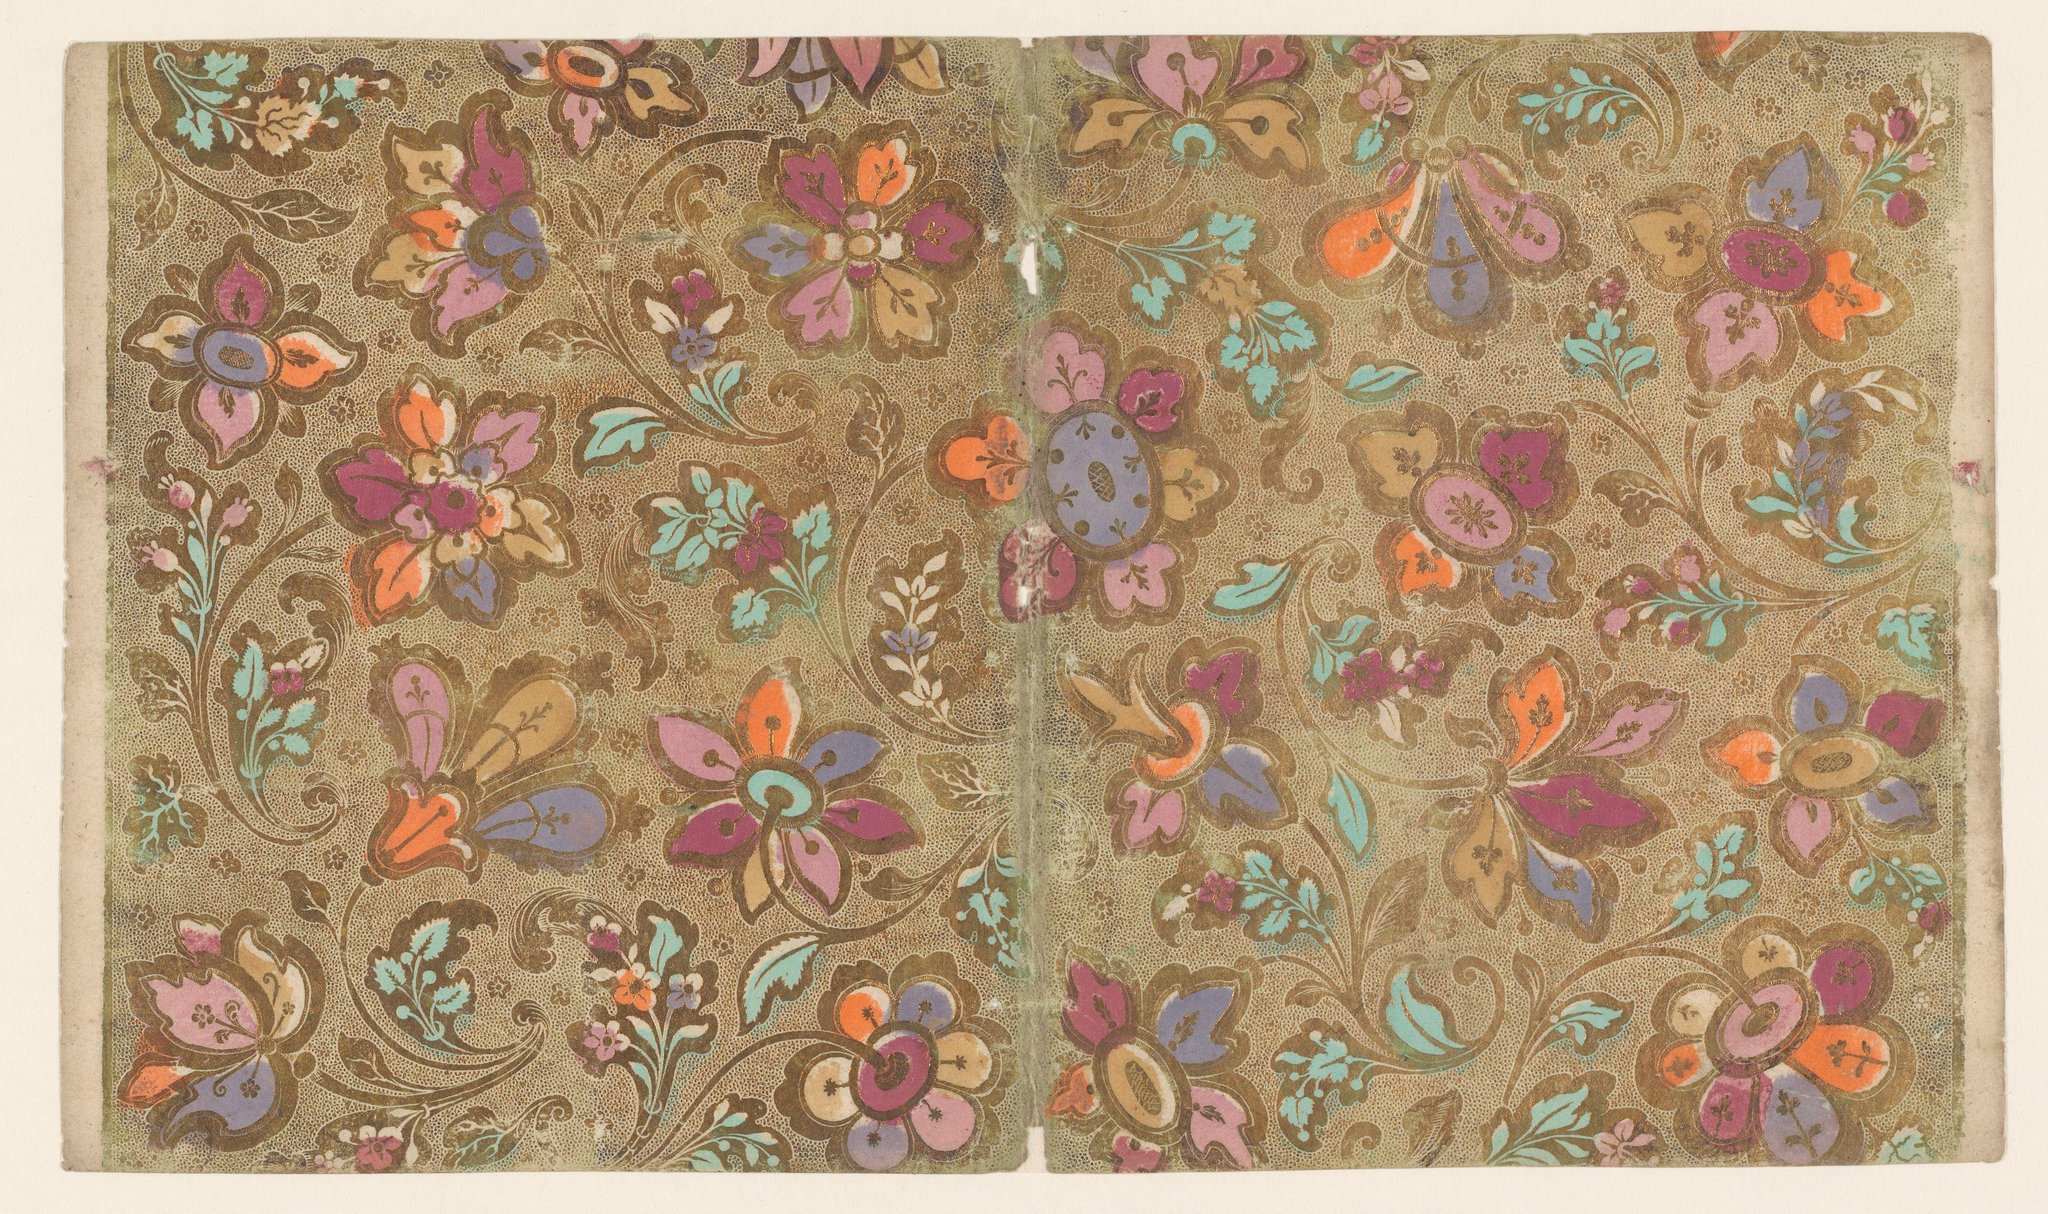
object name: brocade paper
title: Blad met strooipatroon van bloemen op puntenfond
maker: Anonymous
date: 1715-1755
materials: gold leaf, paint, paper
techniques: relief print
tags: ornament derived from plant forms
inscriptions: annotation: ‘1734’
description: Blad met strooipatroon van bloemen op puntenfond. Gebruikt als omslag voor een publicatie uit 1734.